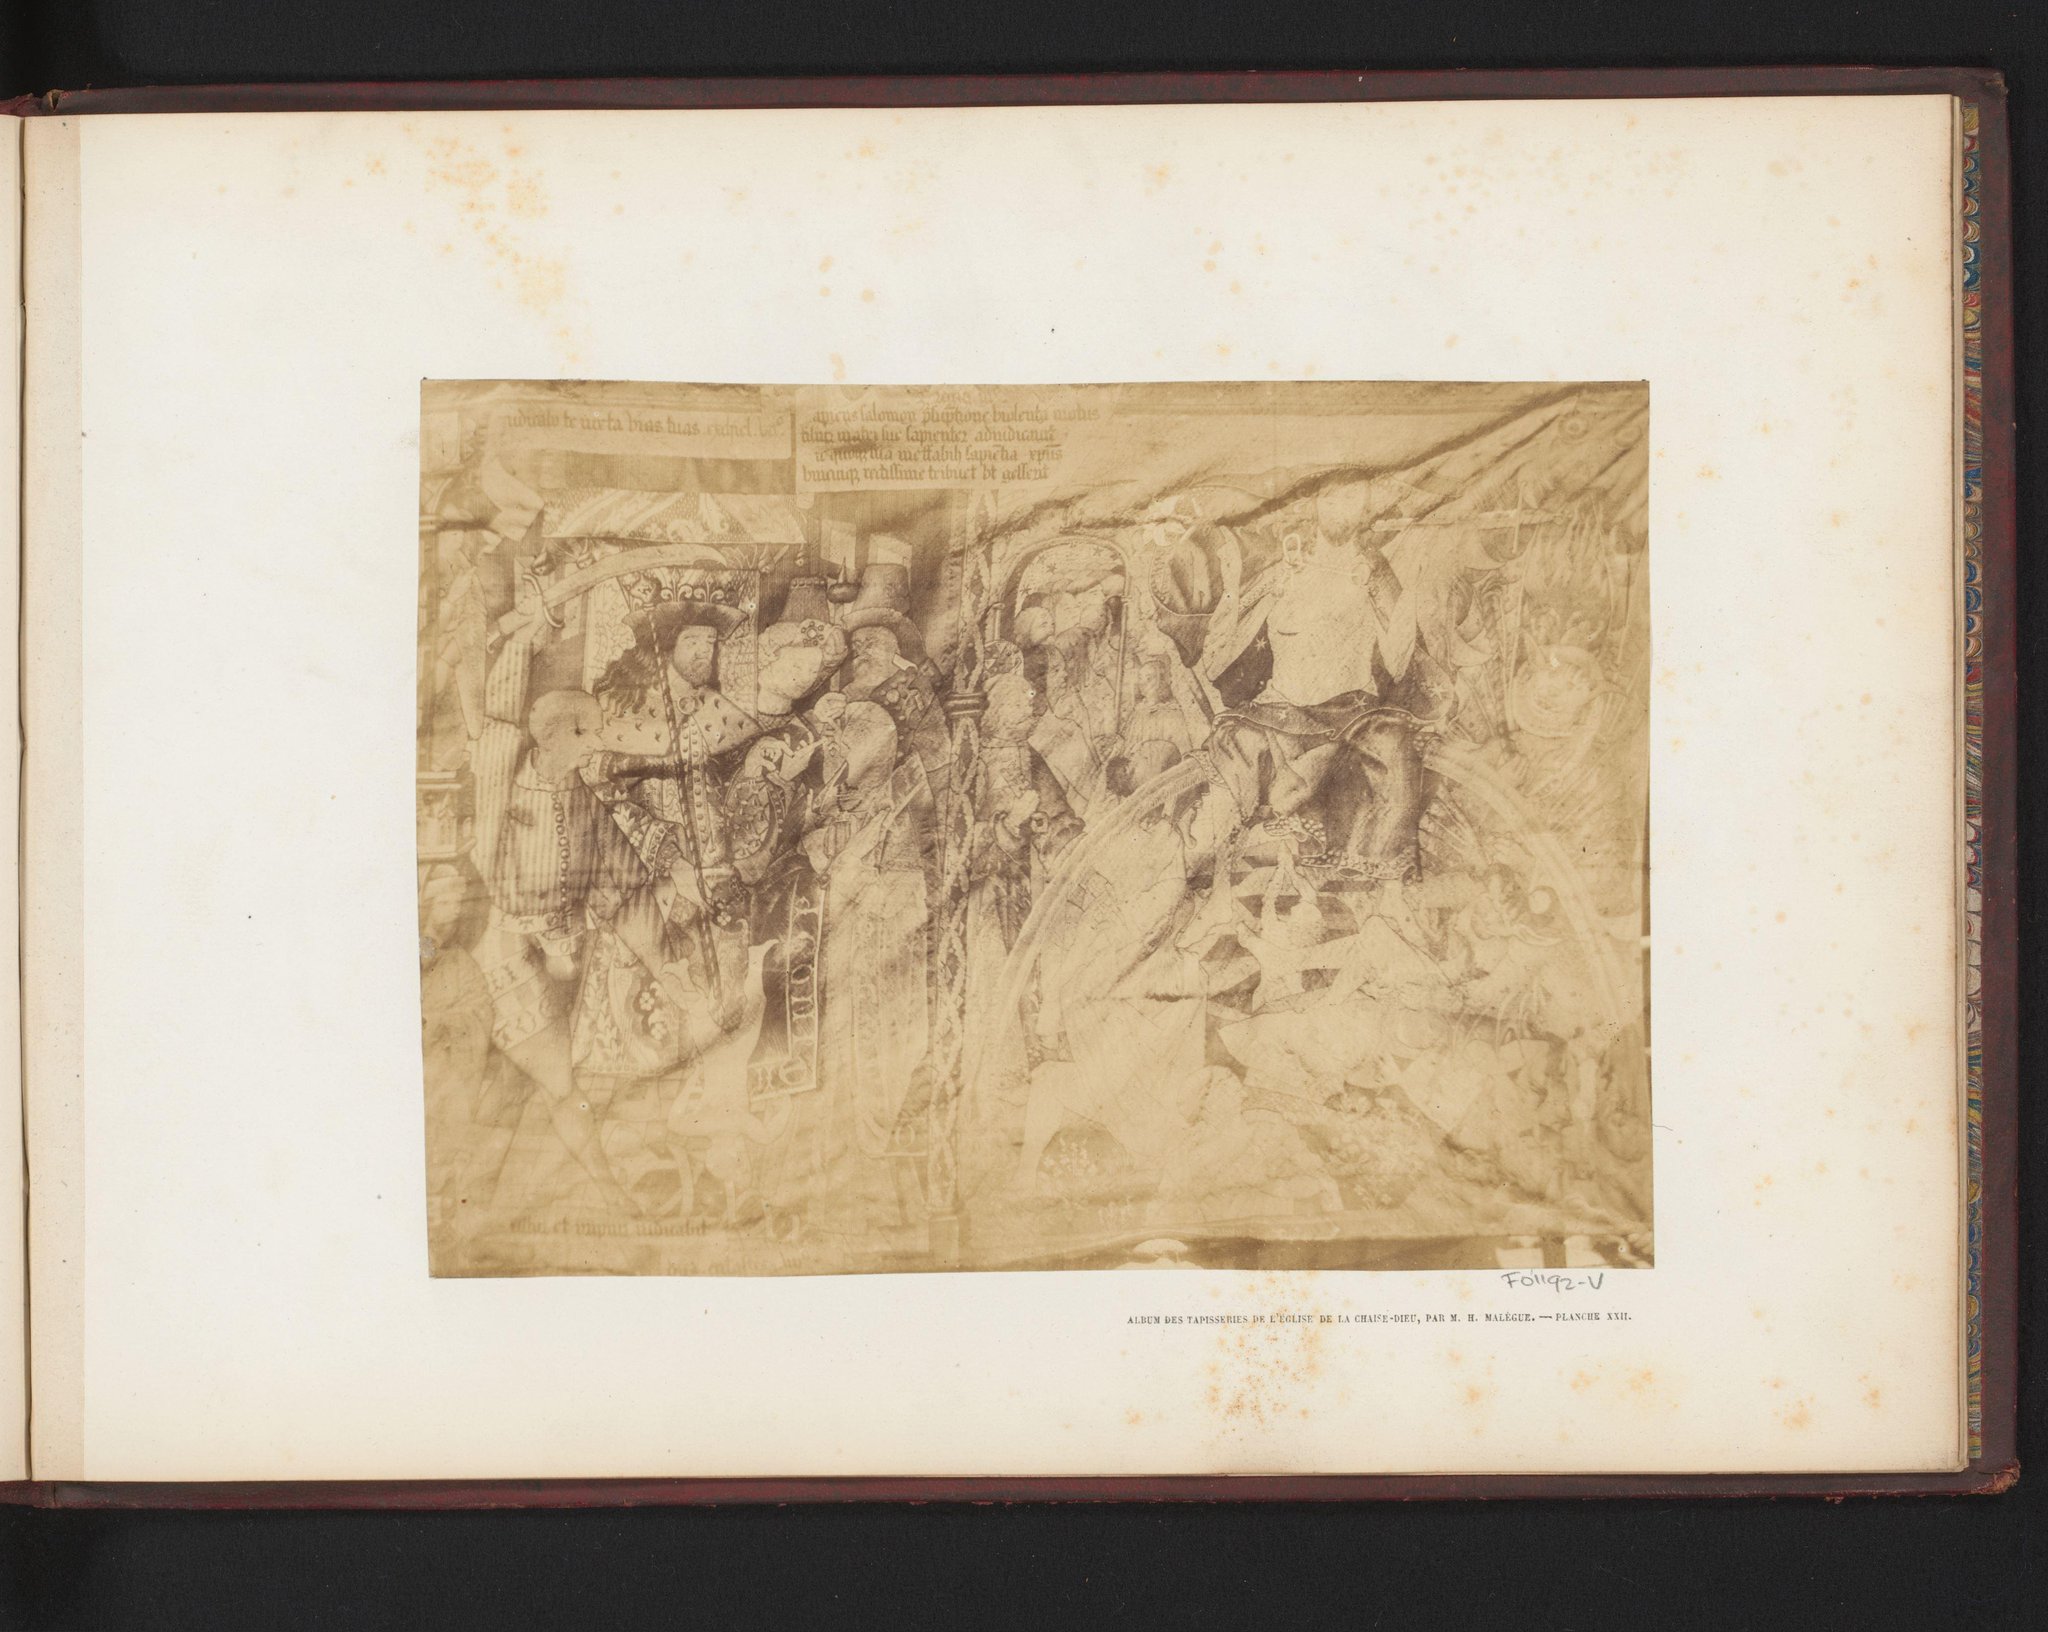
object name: photograph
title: Tapijt met het oordeel van Salomo, het Laatste Oordeel in een kerk te La Chaise-Dieu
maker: hippolyte malègue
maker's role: archeoloog, fotograaf, schrijver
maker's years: 1825-1901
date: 1868-1873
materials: photographic support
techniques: albumen print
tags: tapestry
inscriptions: inscription: ‘album des tapisseries de l'église de la Chaise-Dieu, par M. H. Malegue - Planche XXII’